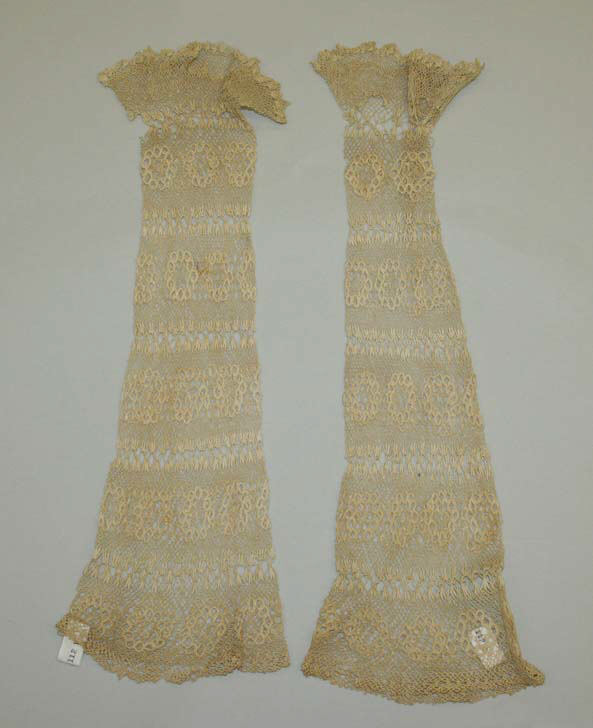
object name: mitt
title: Mitts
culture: american or european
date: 1850-1900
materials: cotton